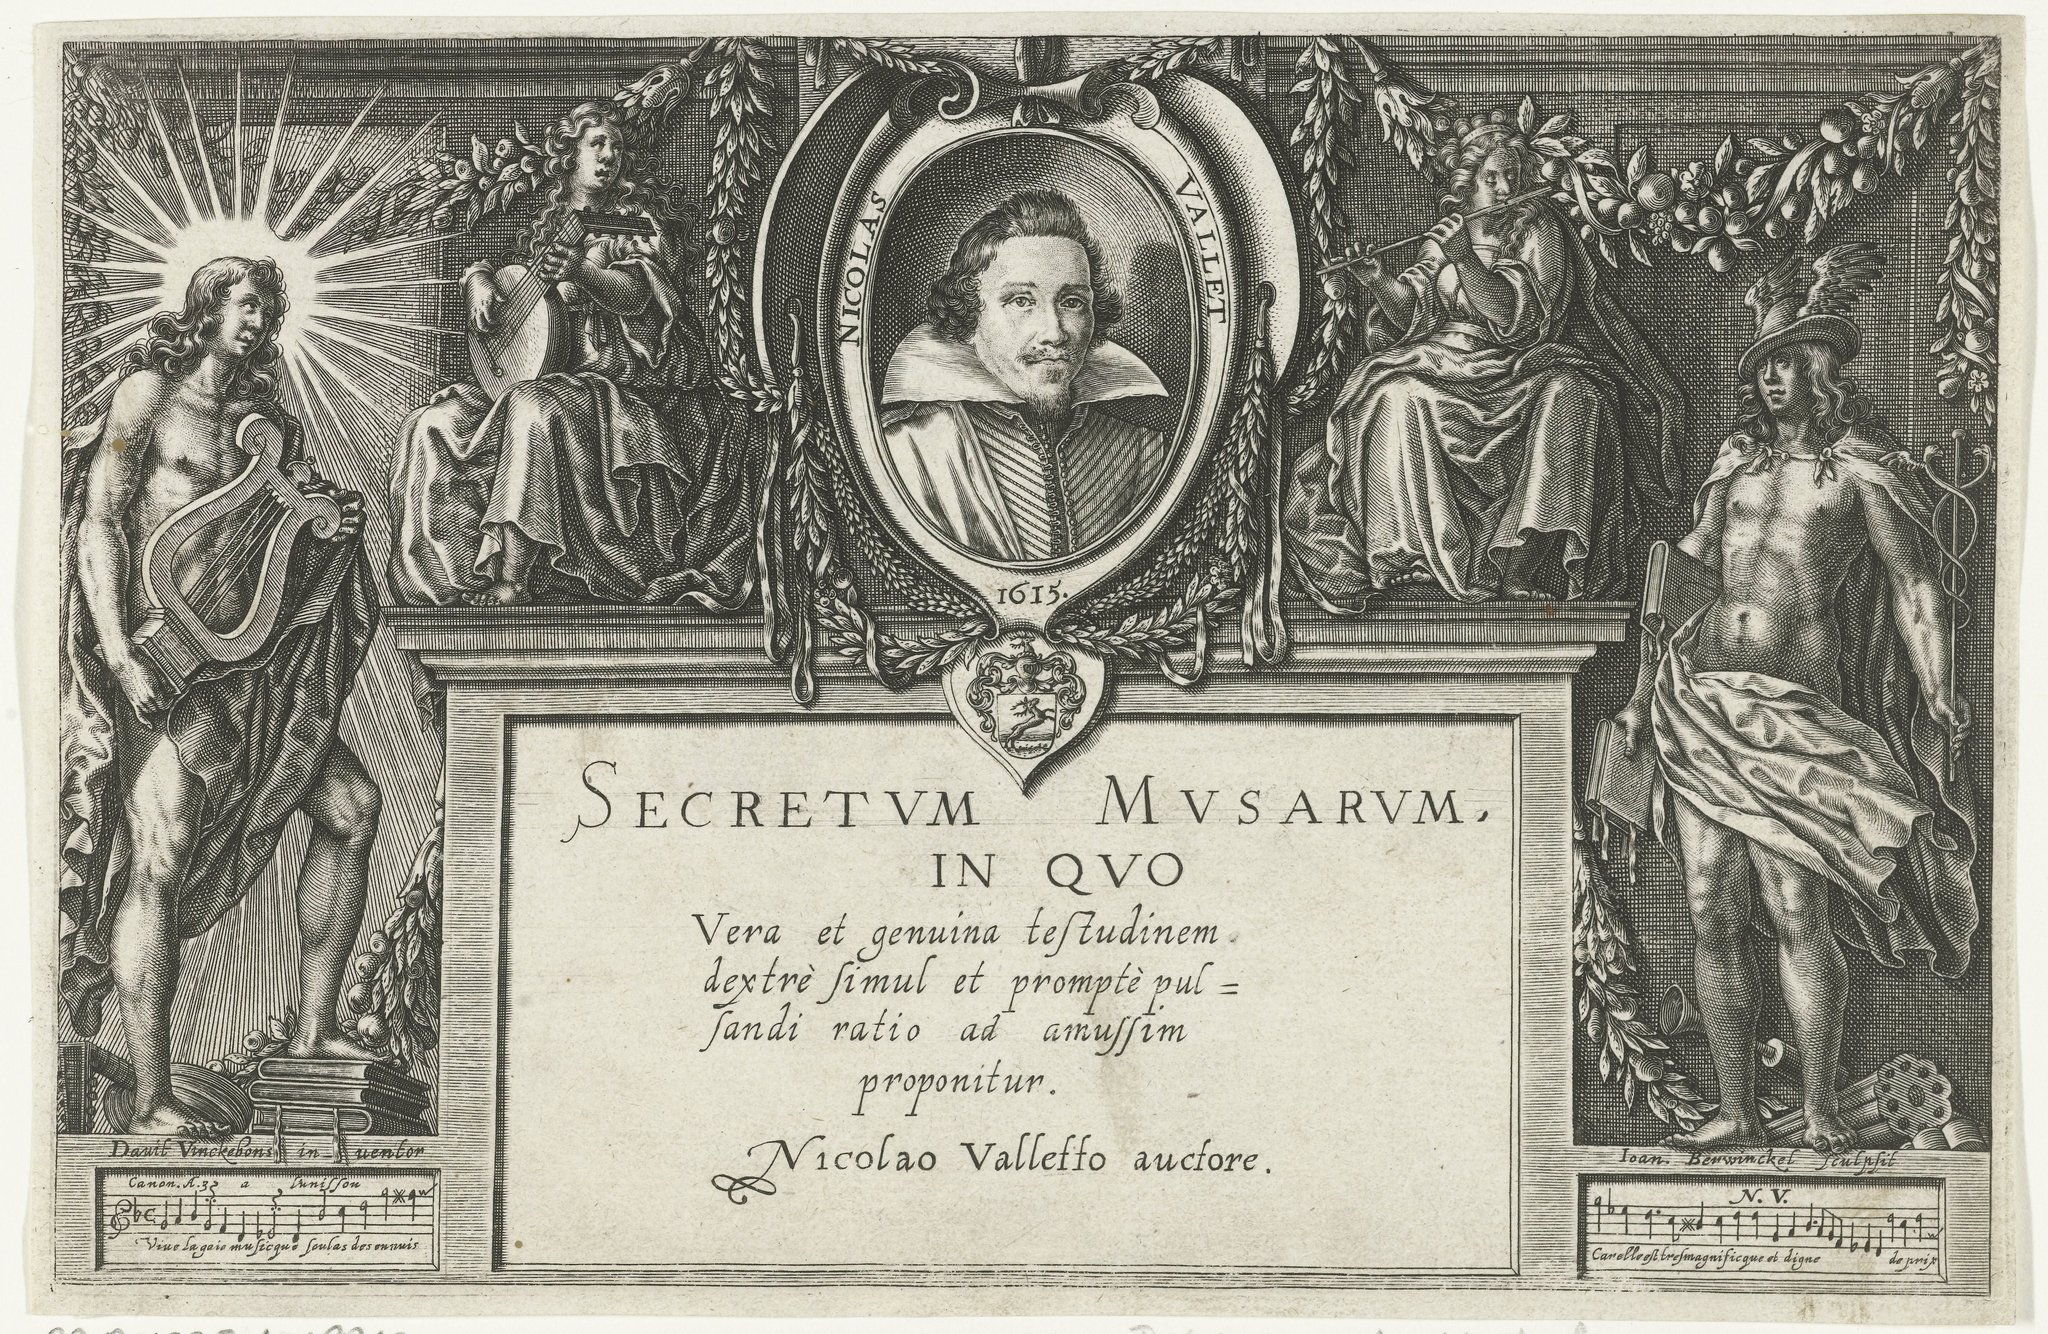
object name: print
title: Titelpagina voor: Nicolas Vallet, Secretum Musarum, 1615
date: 1590-1615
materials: paper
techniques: engraving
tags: (story of) mercury (hermes), apollo playing the lyre, apollo citharoedus, lute, and special forms of lute, e.g.: theorbo, the composer and his muse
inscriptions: collector's mark: Lugt 2228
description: In cartouche het portret van Nicolas Vallet en zijn wapen boven rechthoekige lijst voor titel. Het portret wordt geflankeerd door twee muzen spelend op een luit en fluit en ornamenten met guirlandes. Aan weerszijden staan twee mythologische figuren, Apollo met lier en zonnestralen en Mercurius met gevleugelde helm en caduceus.